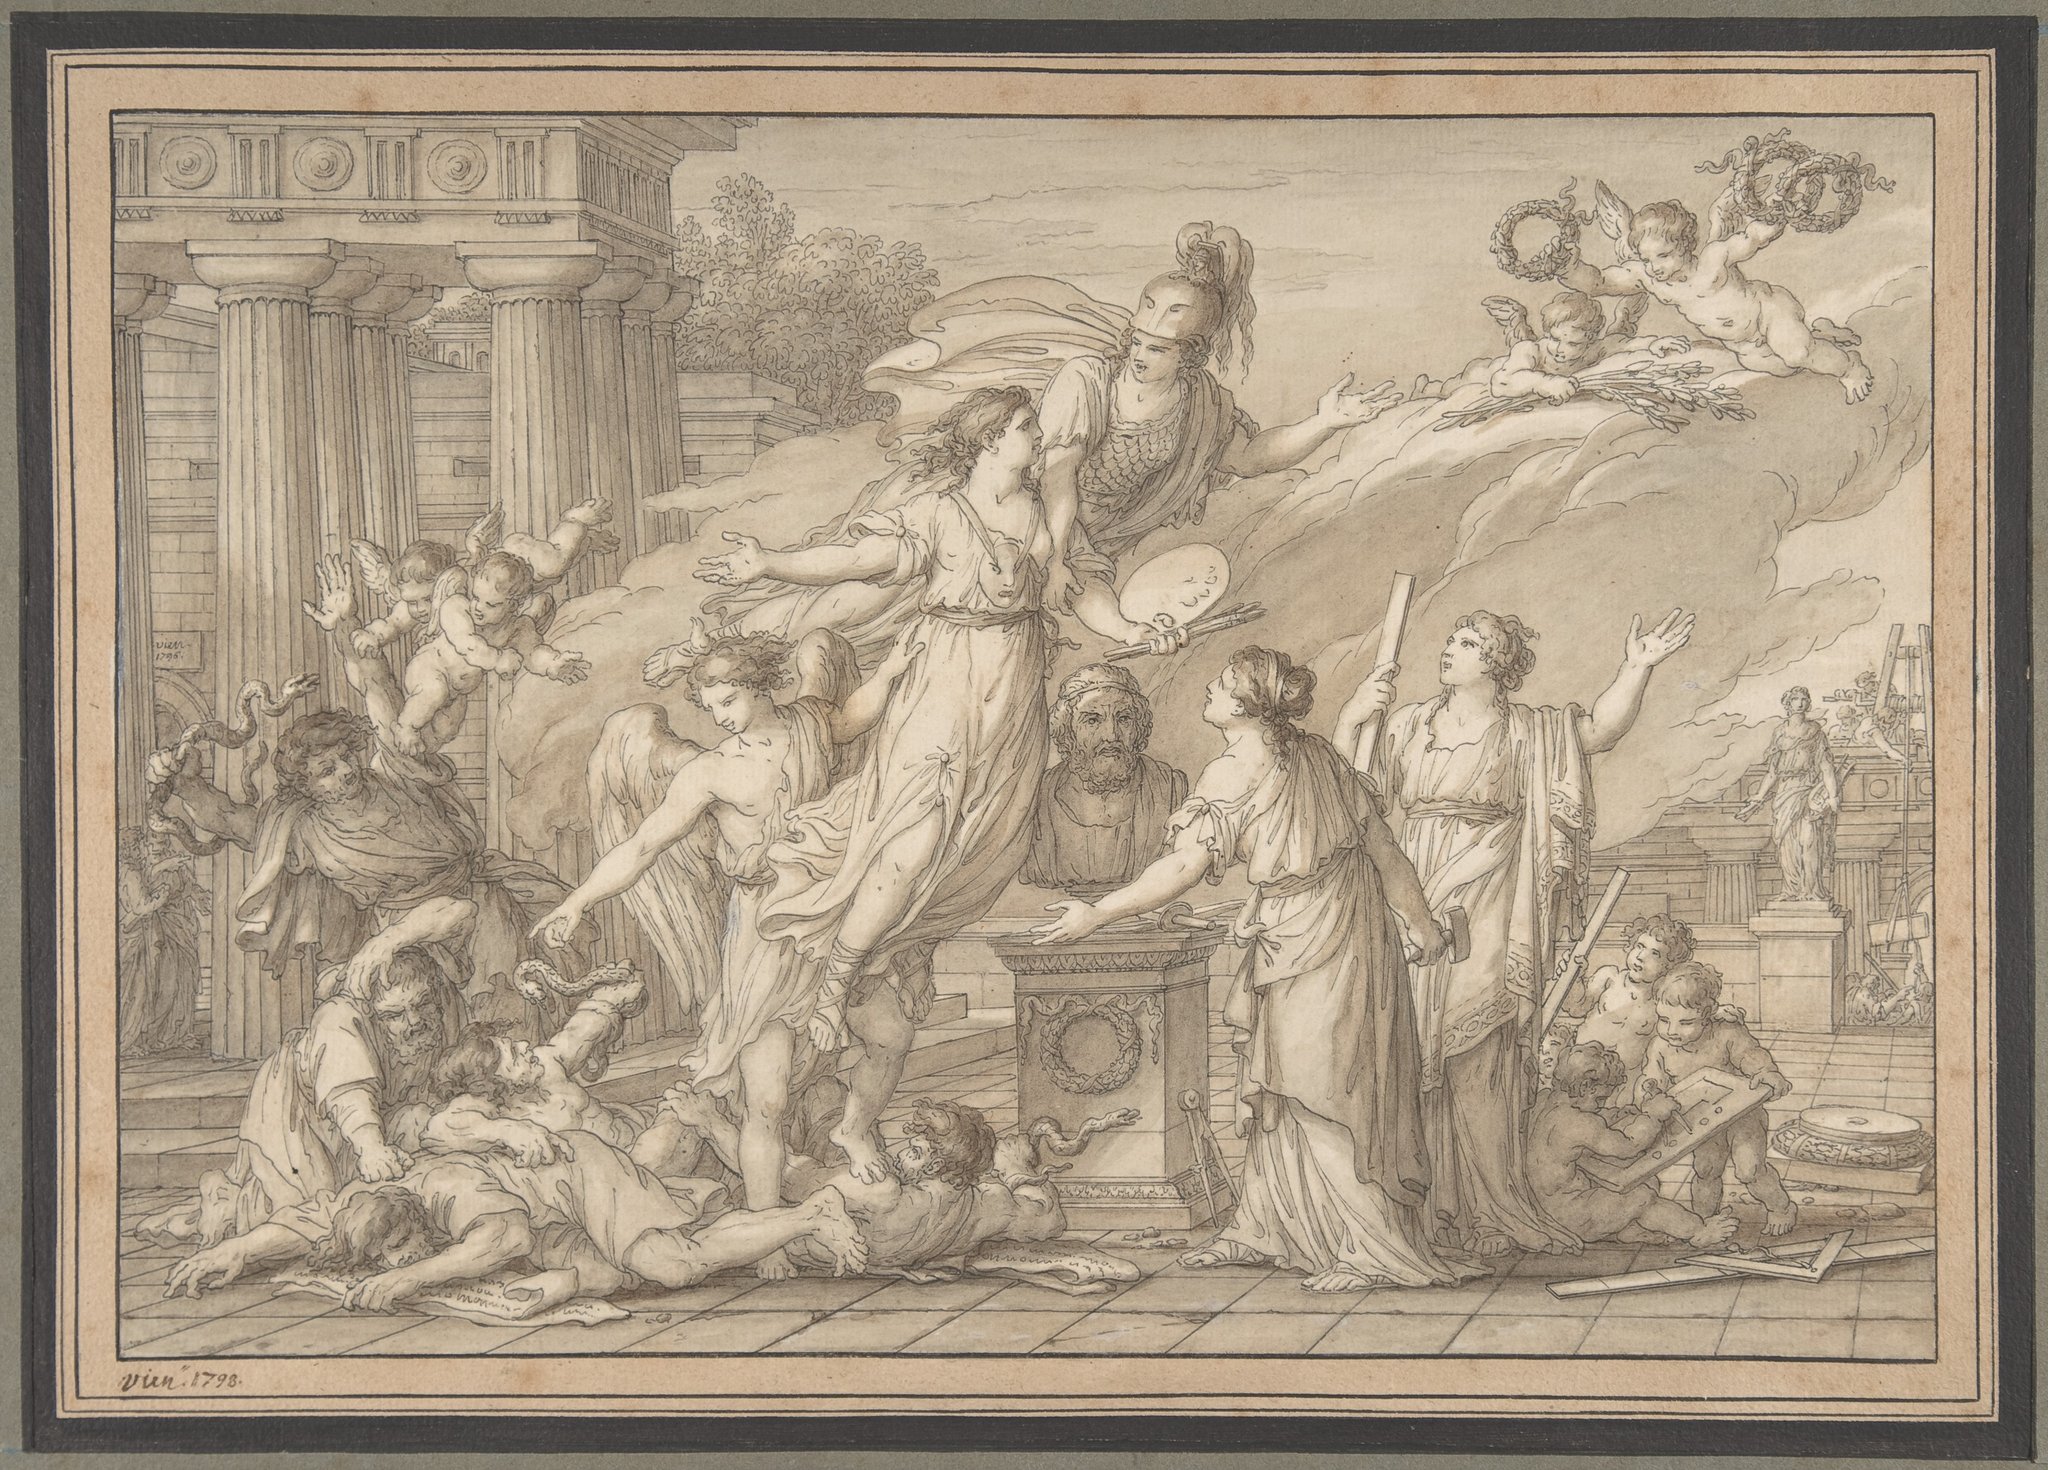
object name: drawing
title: Allegory of the Arts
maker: joseph marie vien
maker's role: artist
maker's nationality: french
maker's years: 1716-1809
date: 1796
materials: chalk, ink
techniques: brush, pen, drawing, wash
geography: france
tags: men,women